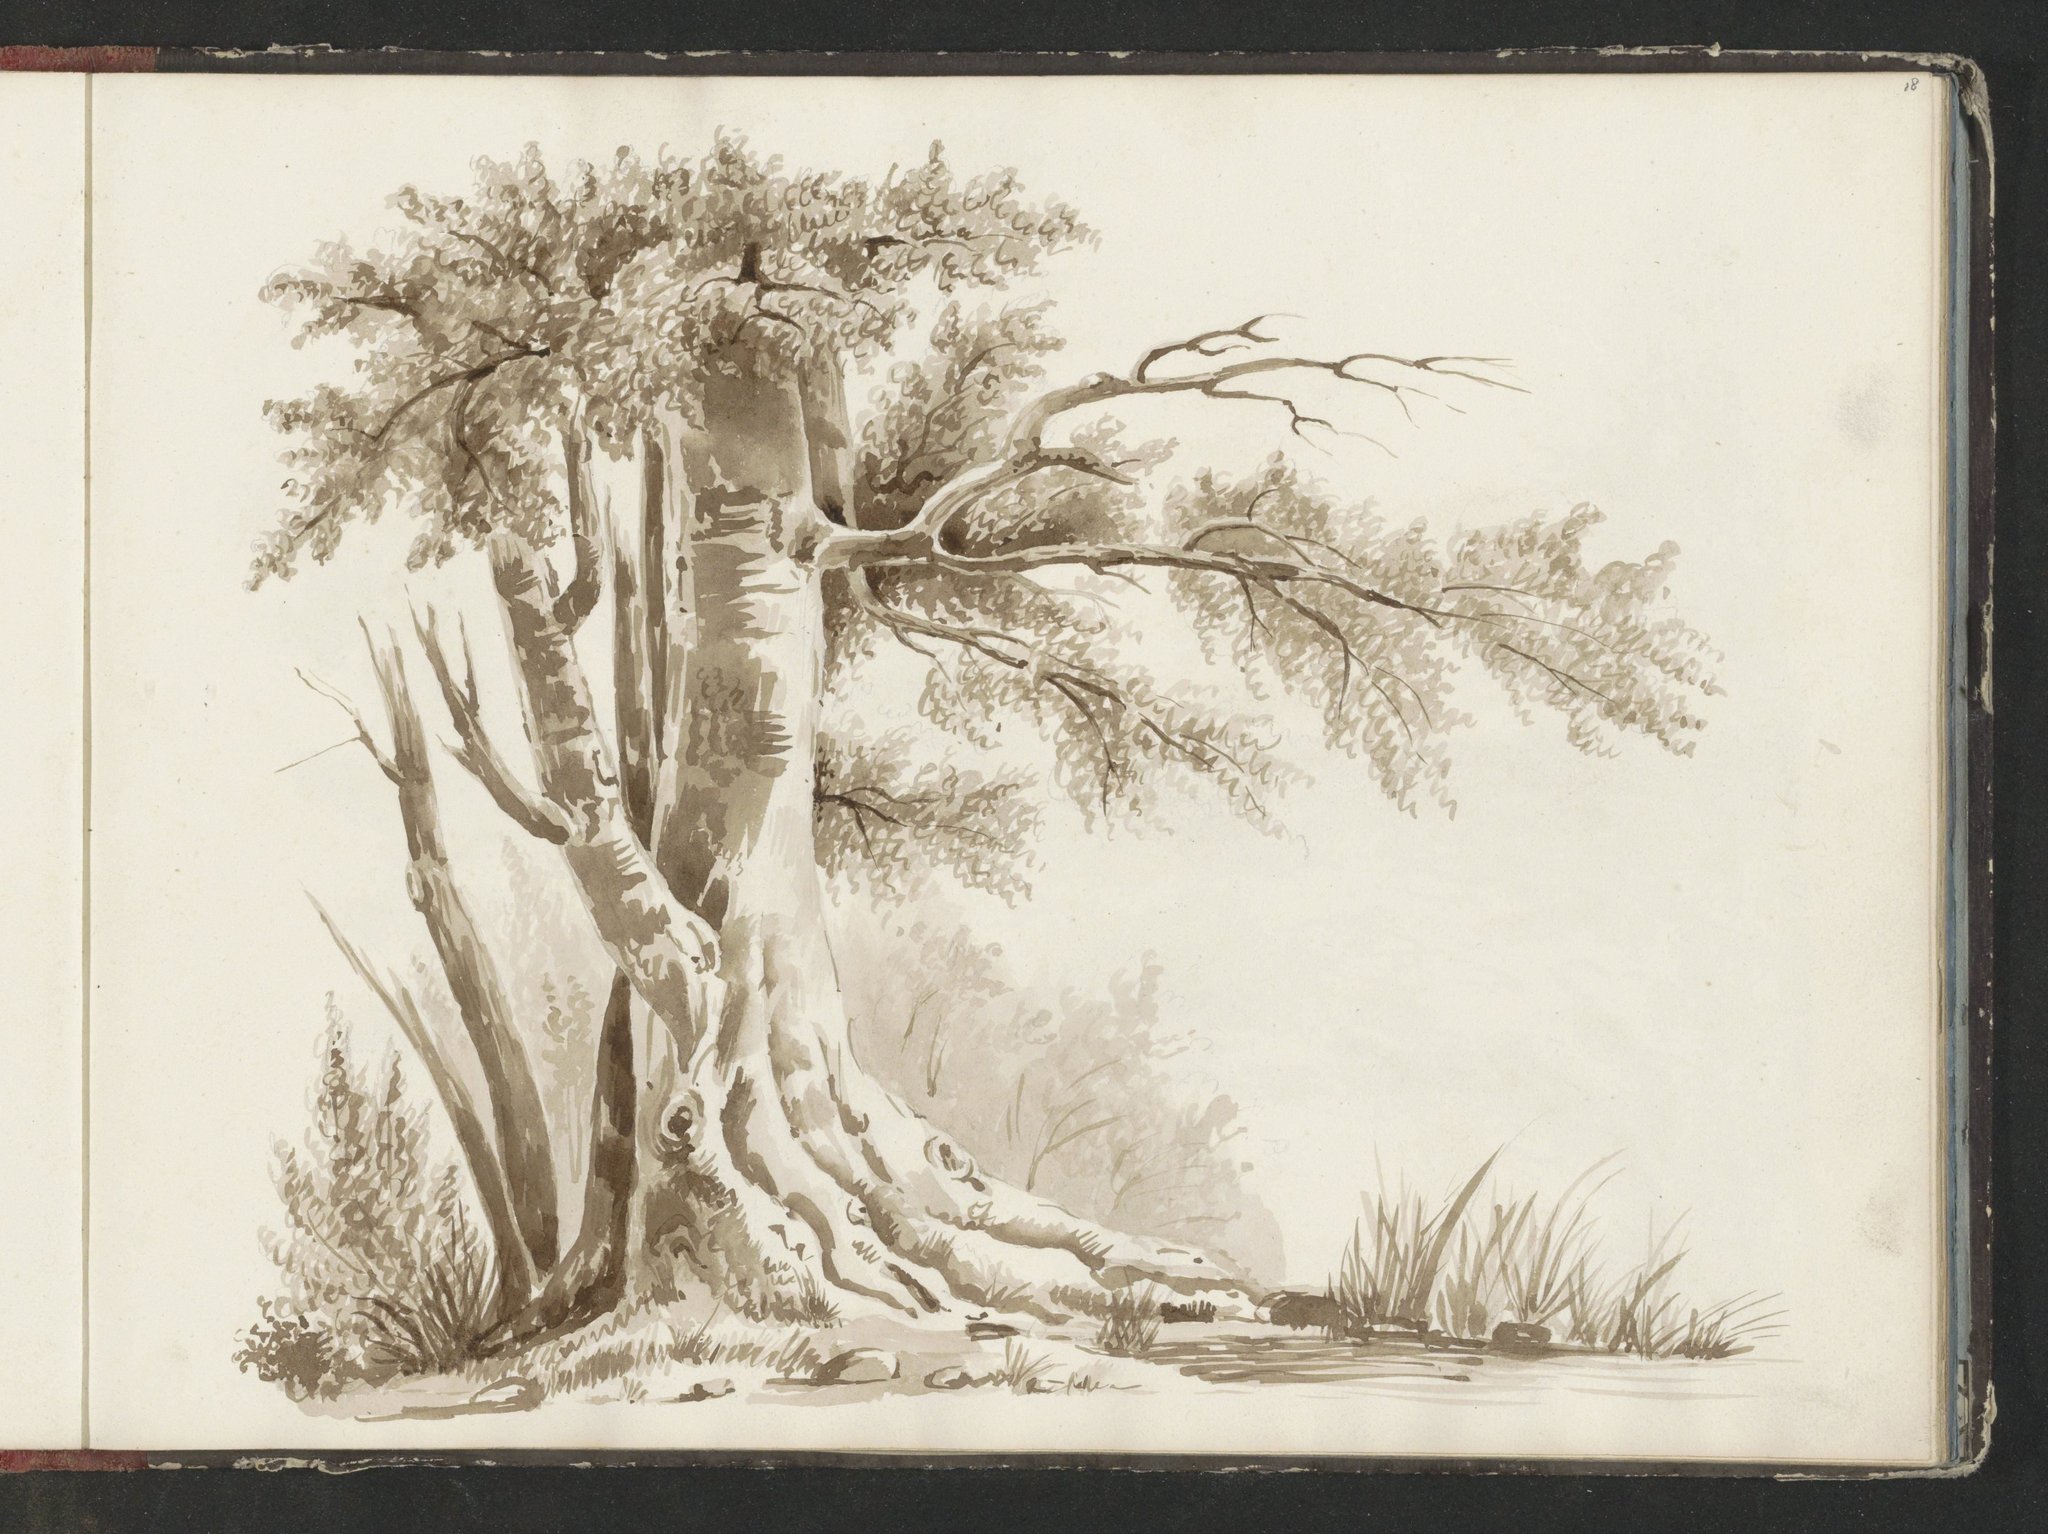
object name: sketchbook leaf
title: Boom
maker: Anonymous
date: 1819-1870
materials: ink, paper, pencil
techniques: brush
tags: trees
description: Blad 18 recto uit een schetsboek met 39 bladen.